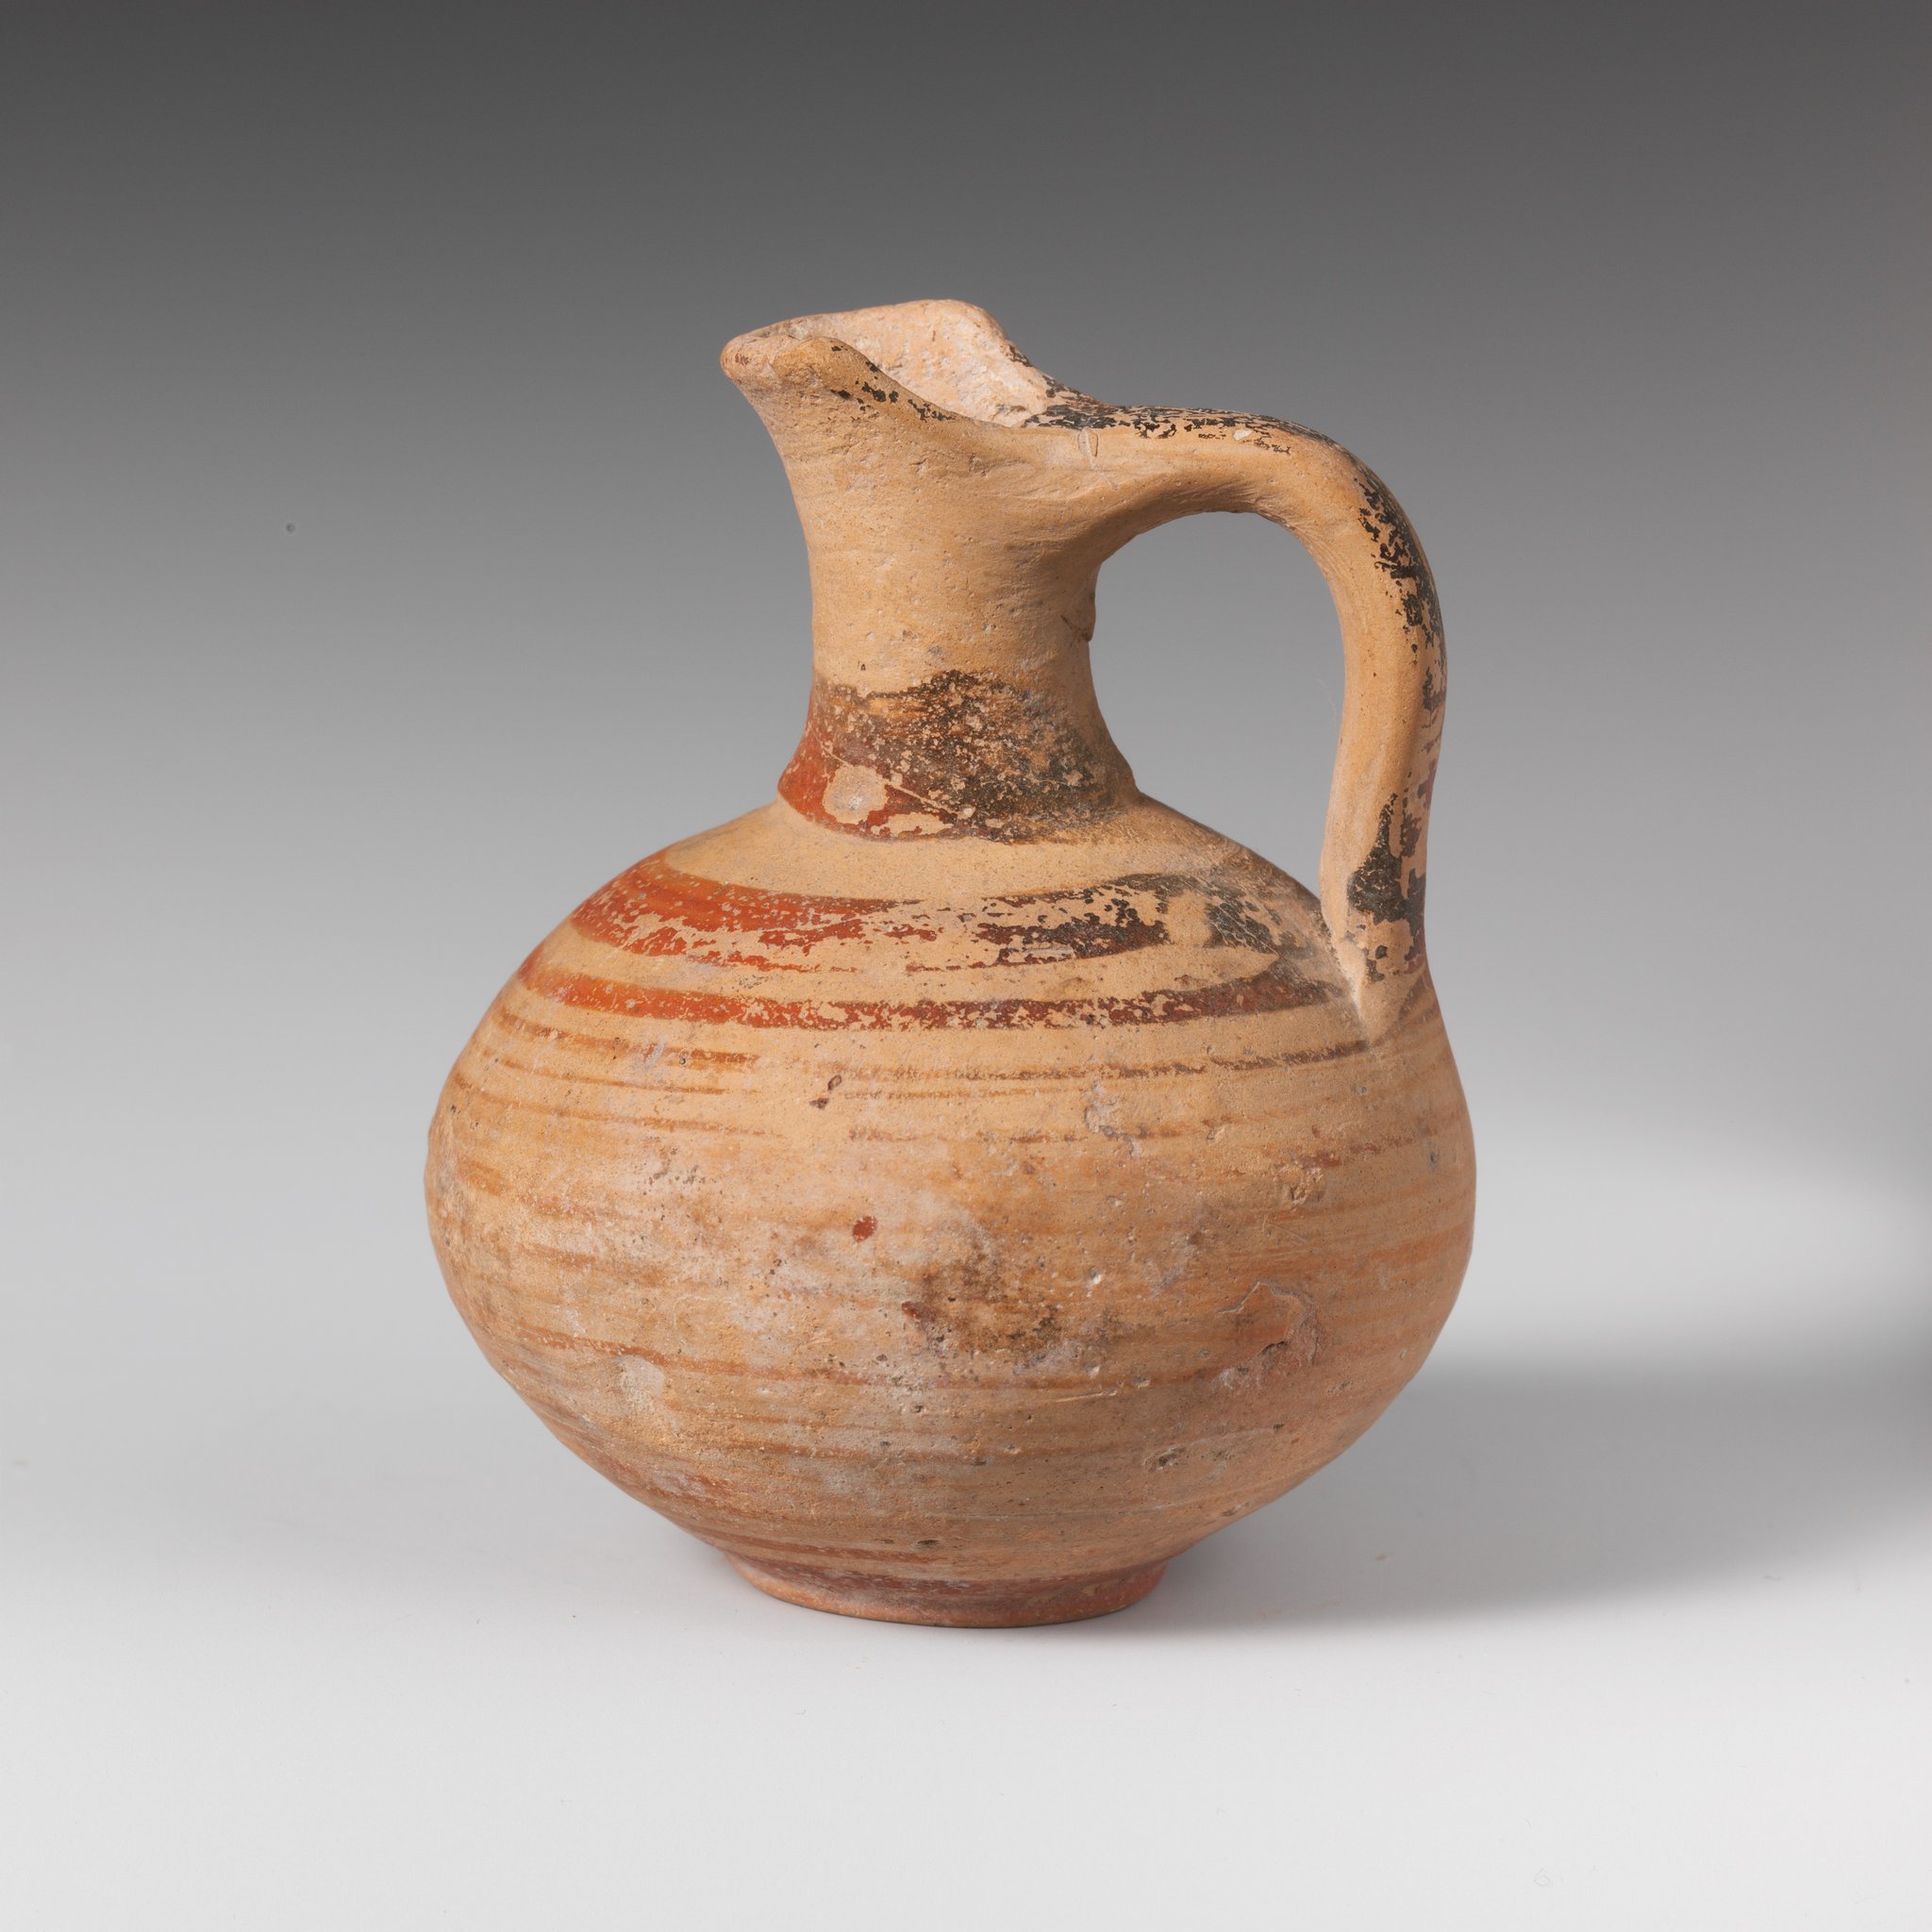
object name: jug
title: Terracotta jug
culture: mycenaean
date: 1600-1050 BCE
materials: terracotta